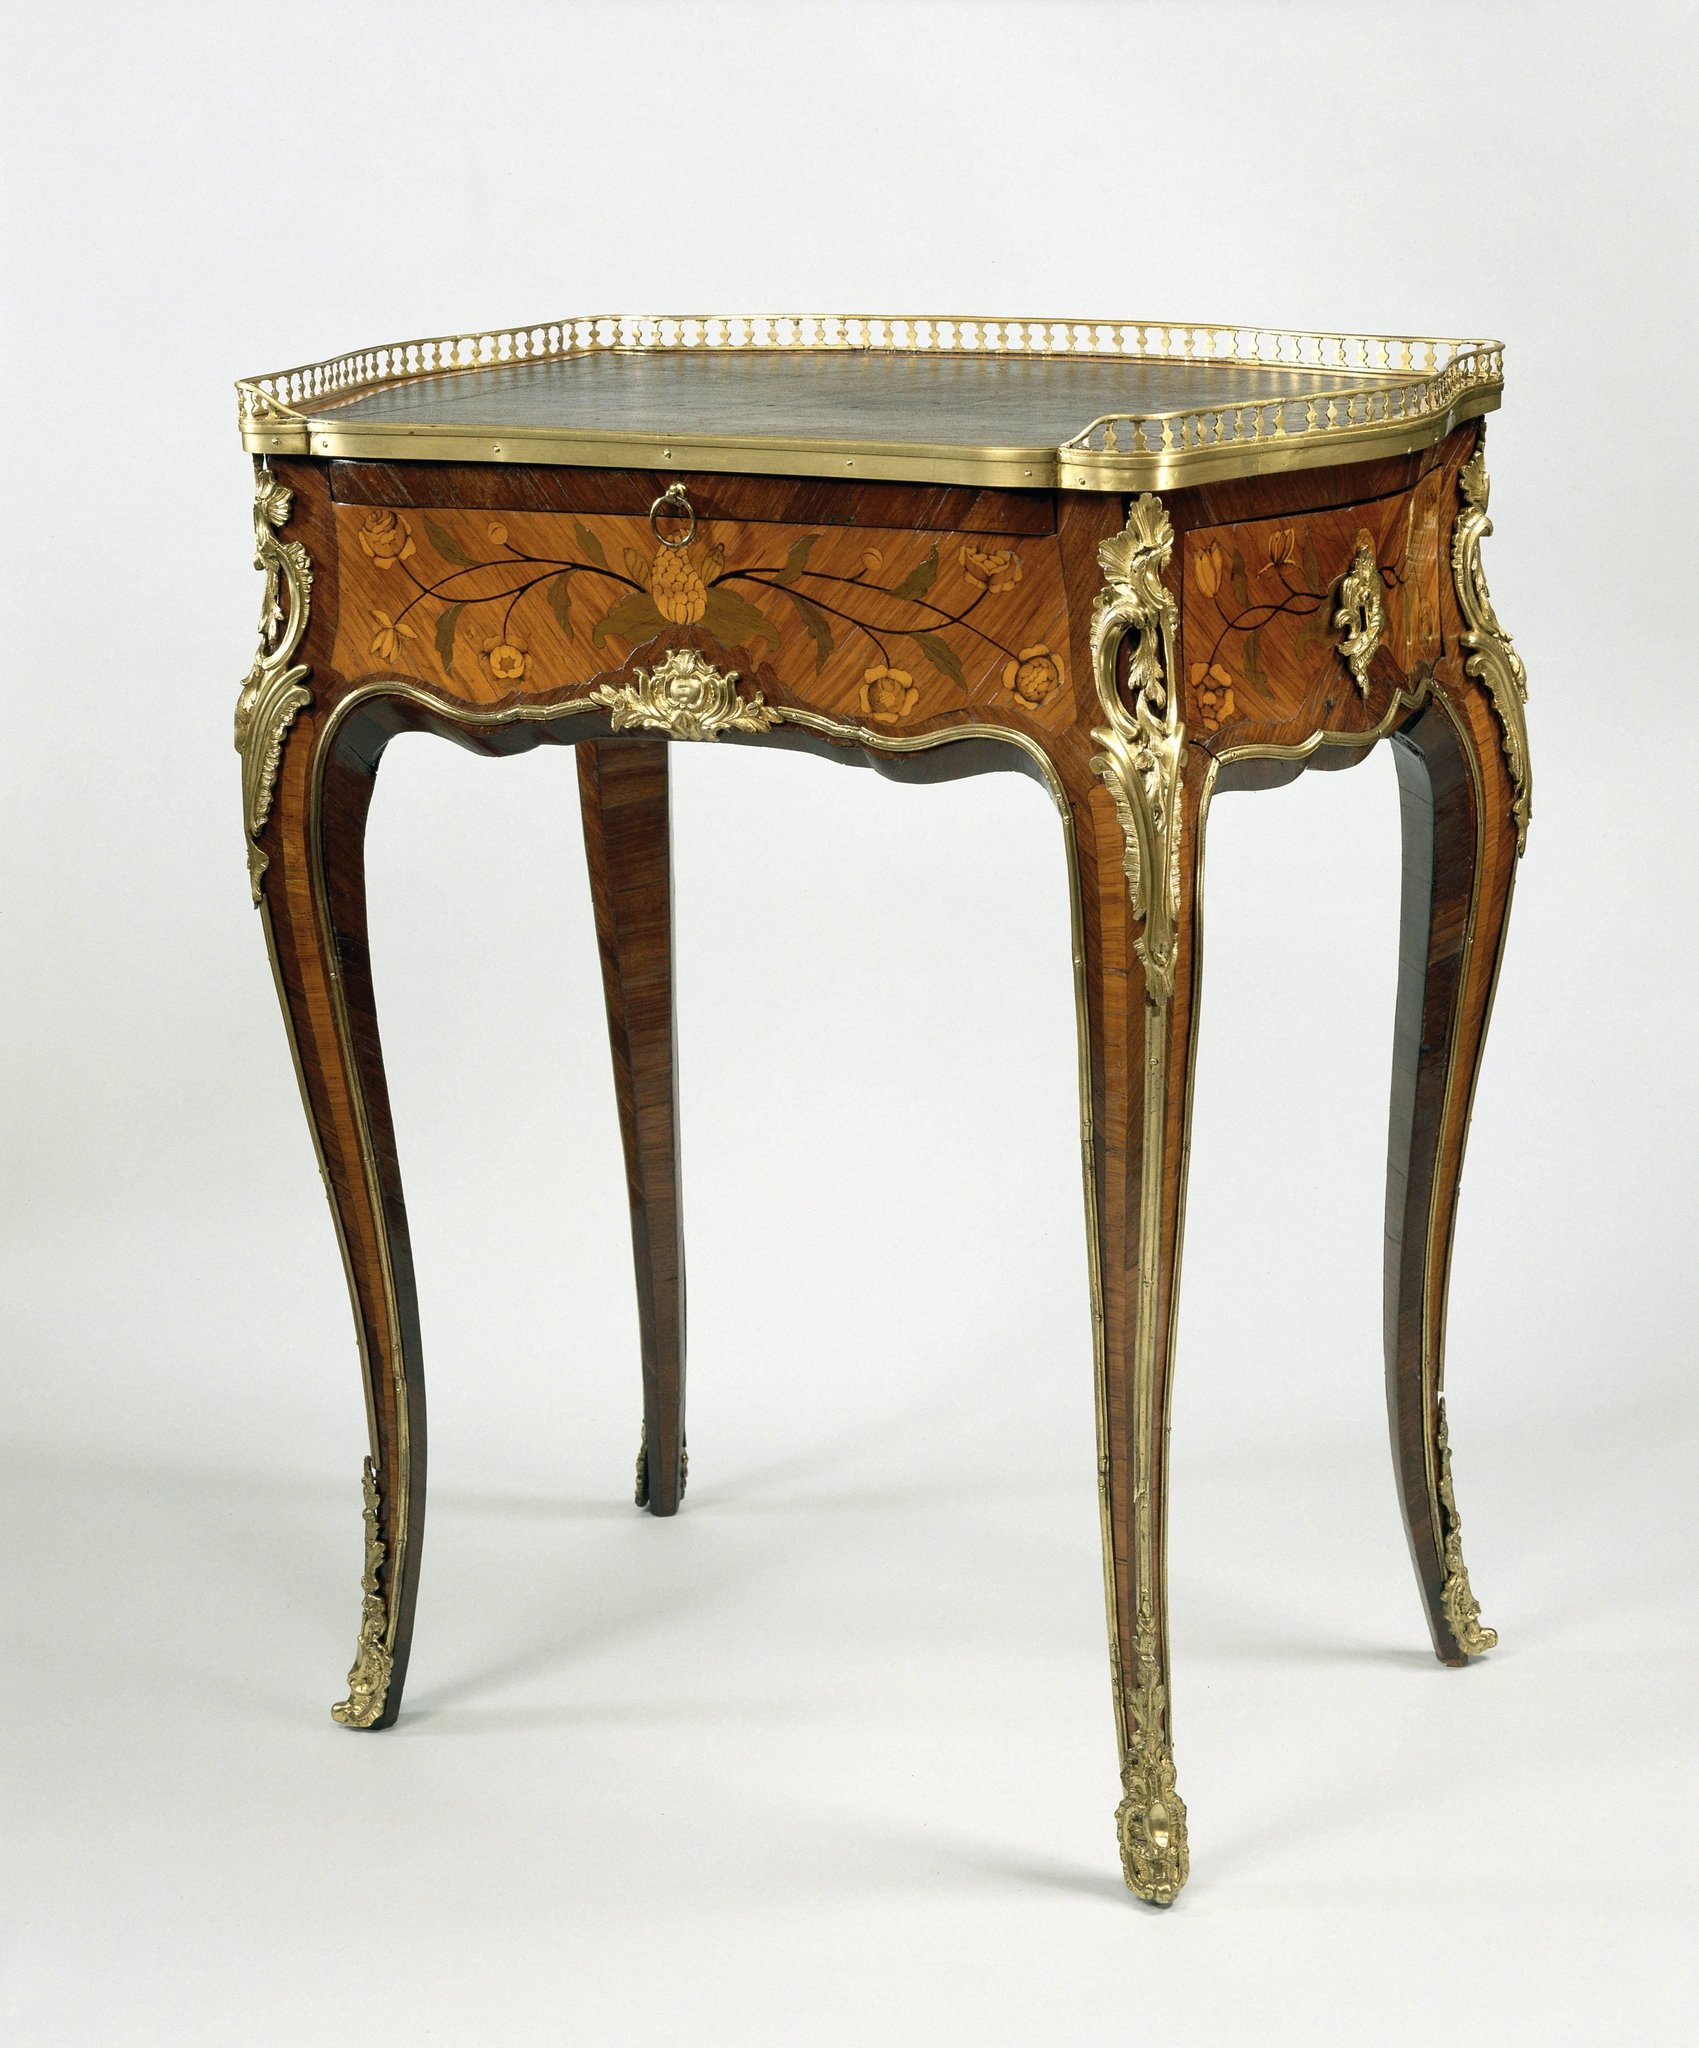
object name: table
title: Tafel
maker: charles marie cochois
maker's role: furniture worker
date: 1750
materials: bronze, wood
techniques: gilding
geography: france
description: Panel from a room. Oak. Paris, c. 1740. Cartel clock. Gilt bronze. Paris, c. 1740, the case by Jacques Caffiéri, the movement by Julien le Roy. Writing table. Oak, veneered with tulipwood, purplewood and other woods. The leather top is probably a replacement for a decoration in marquetry. Paris, ca. 1750, by Charles Marie Cochois. Ewer. Porcelain mounted in gilt bronze. The porcelain China, c. 1700 - 1750, the mounts Paris, c. 1750.